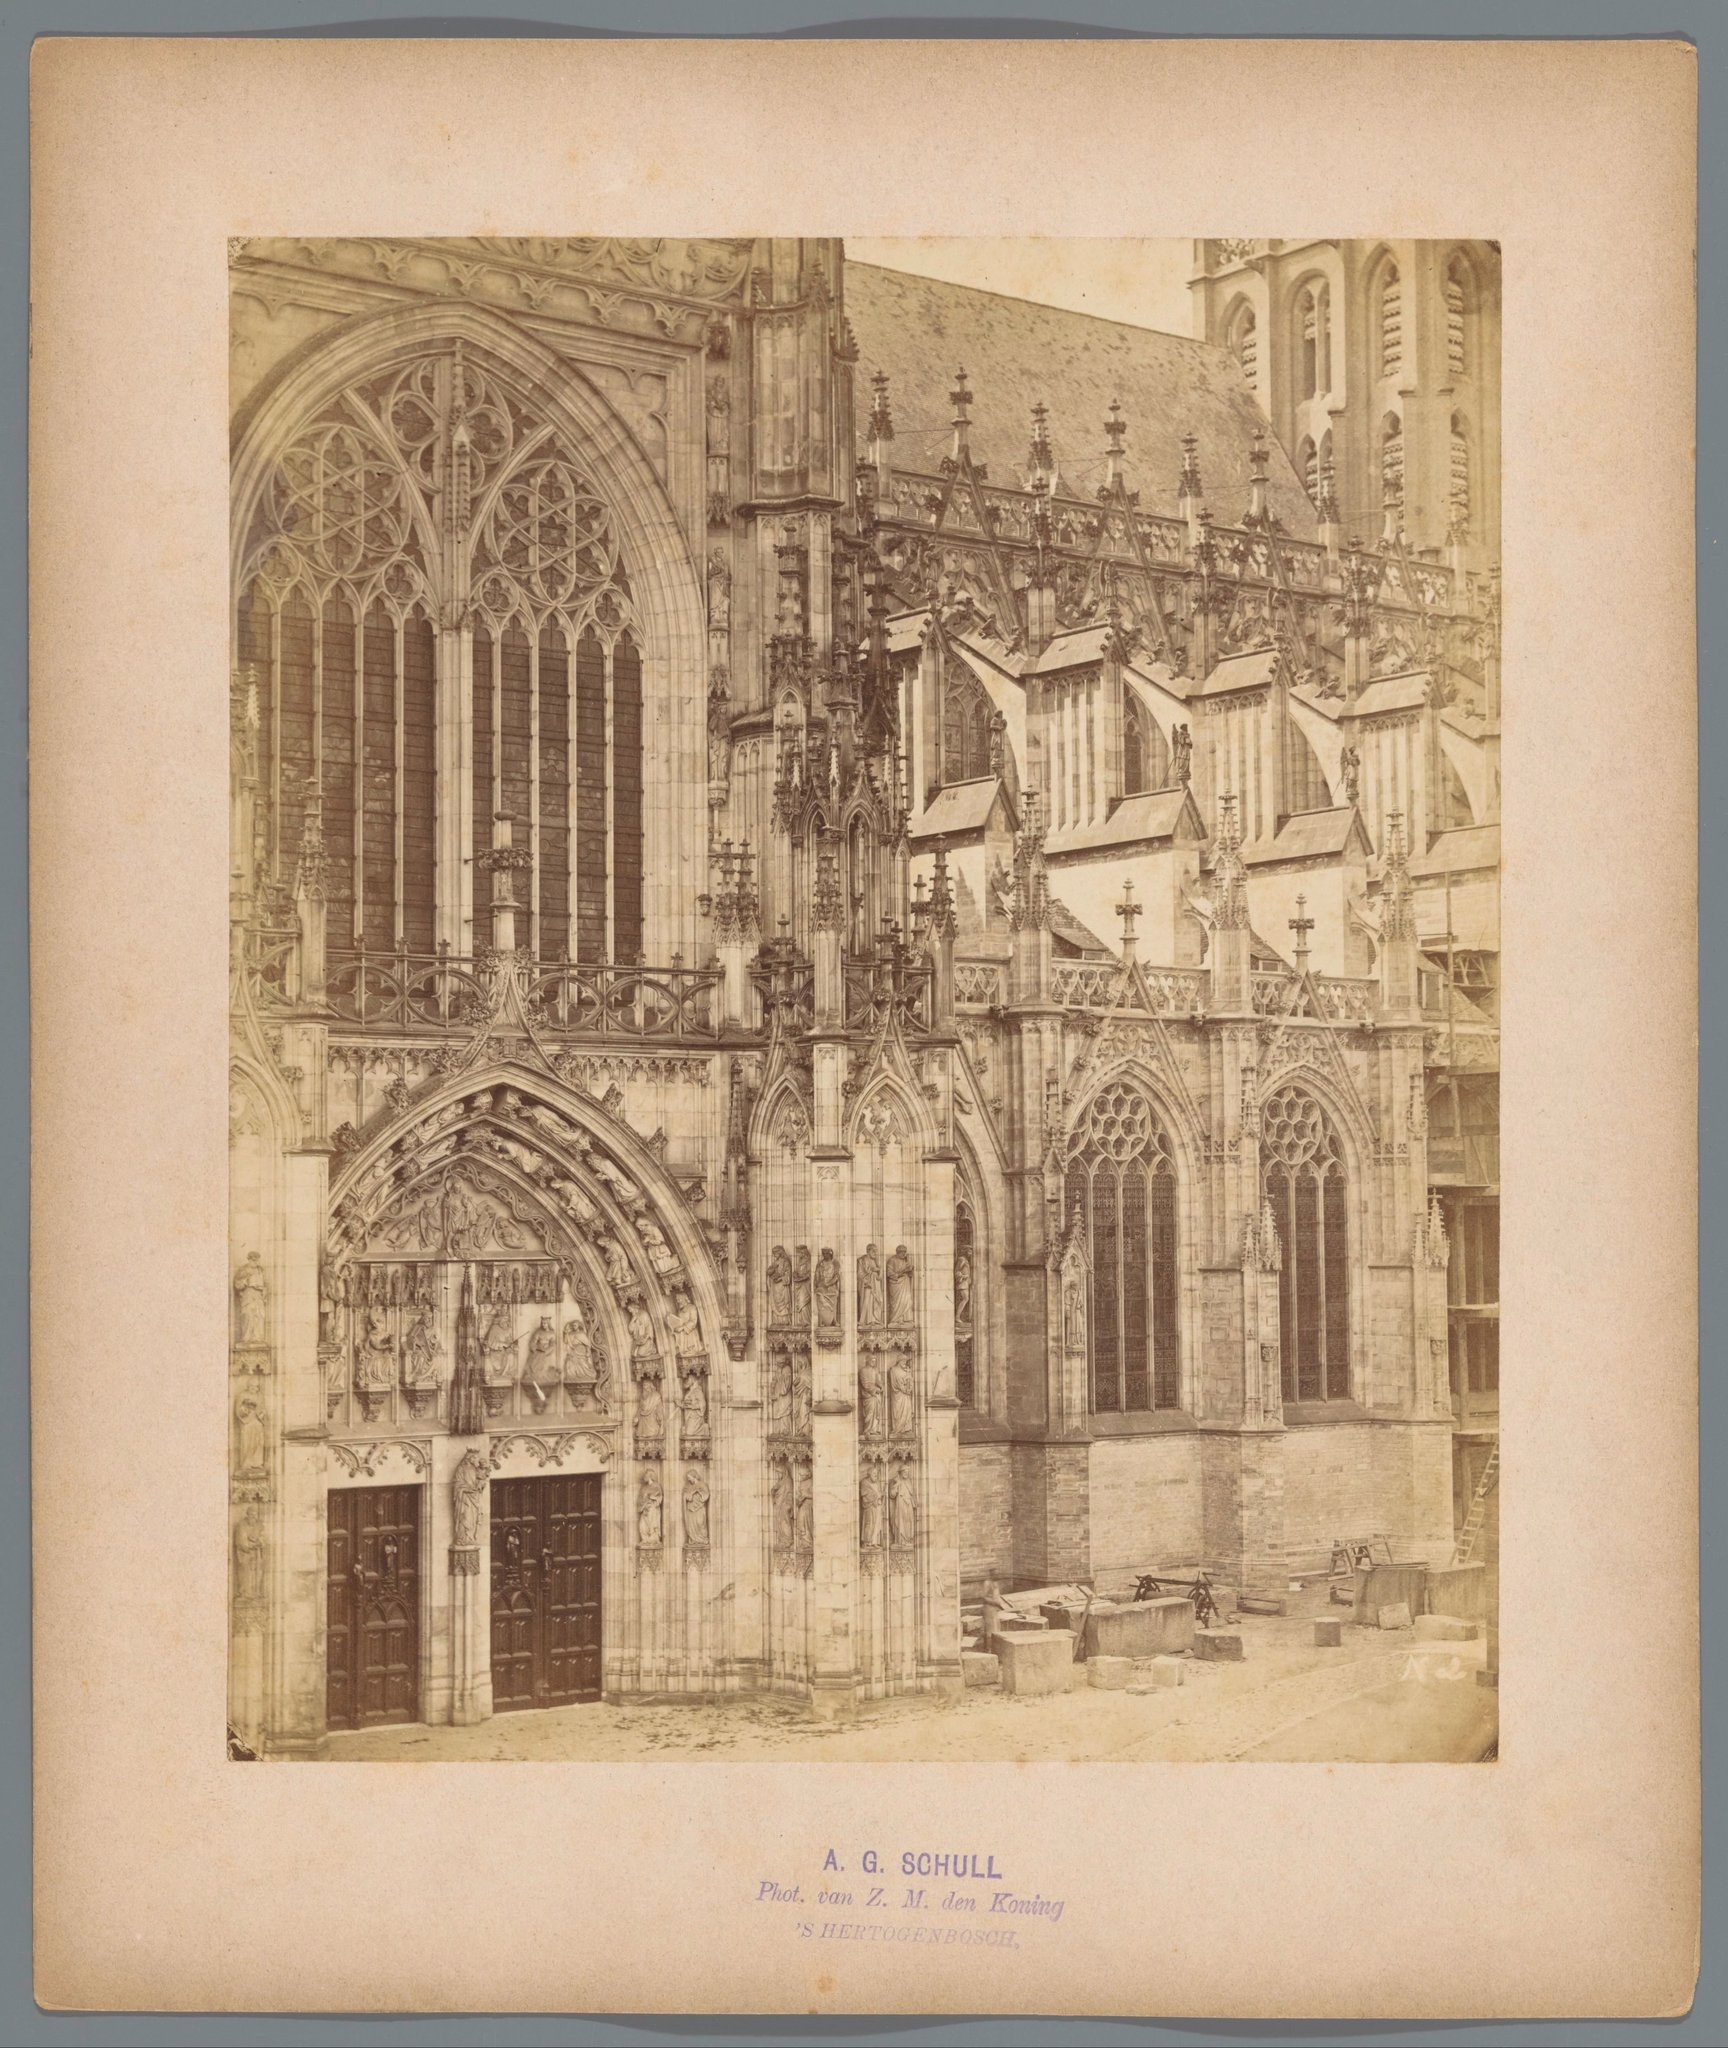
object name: photograph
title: Deel van de gevel van de Sint-Janskathedraal te 's-Hertogenbosch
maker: antonius godefridus schull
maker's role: fotograaf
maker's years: 1819-1896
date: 1875-1900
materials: cardboard, photographic support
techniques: albumen print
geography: den bosch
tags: parts of church exterior and annexes: portal, church-window, e.g. rose-window, façade (of house or building)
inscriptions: number: ‘N 2’, name: ‘A. G. SCHULL Phot. van Z. M. den Koning 'S HERTOGENBOSCH.’, name: ‘S. FRANCO, b. i. den Haag.’